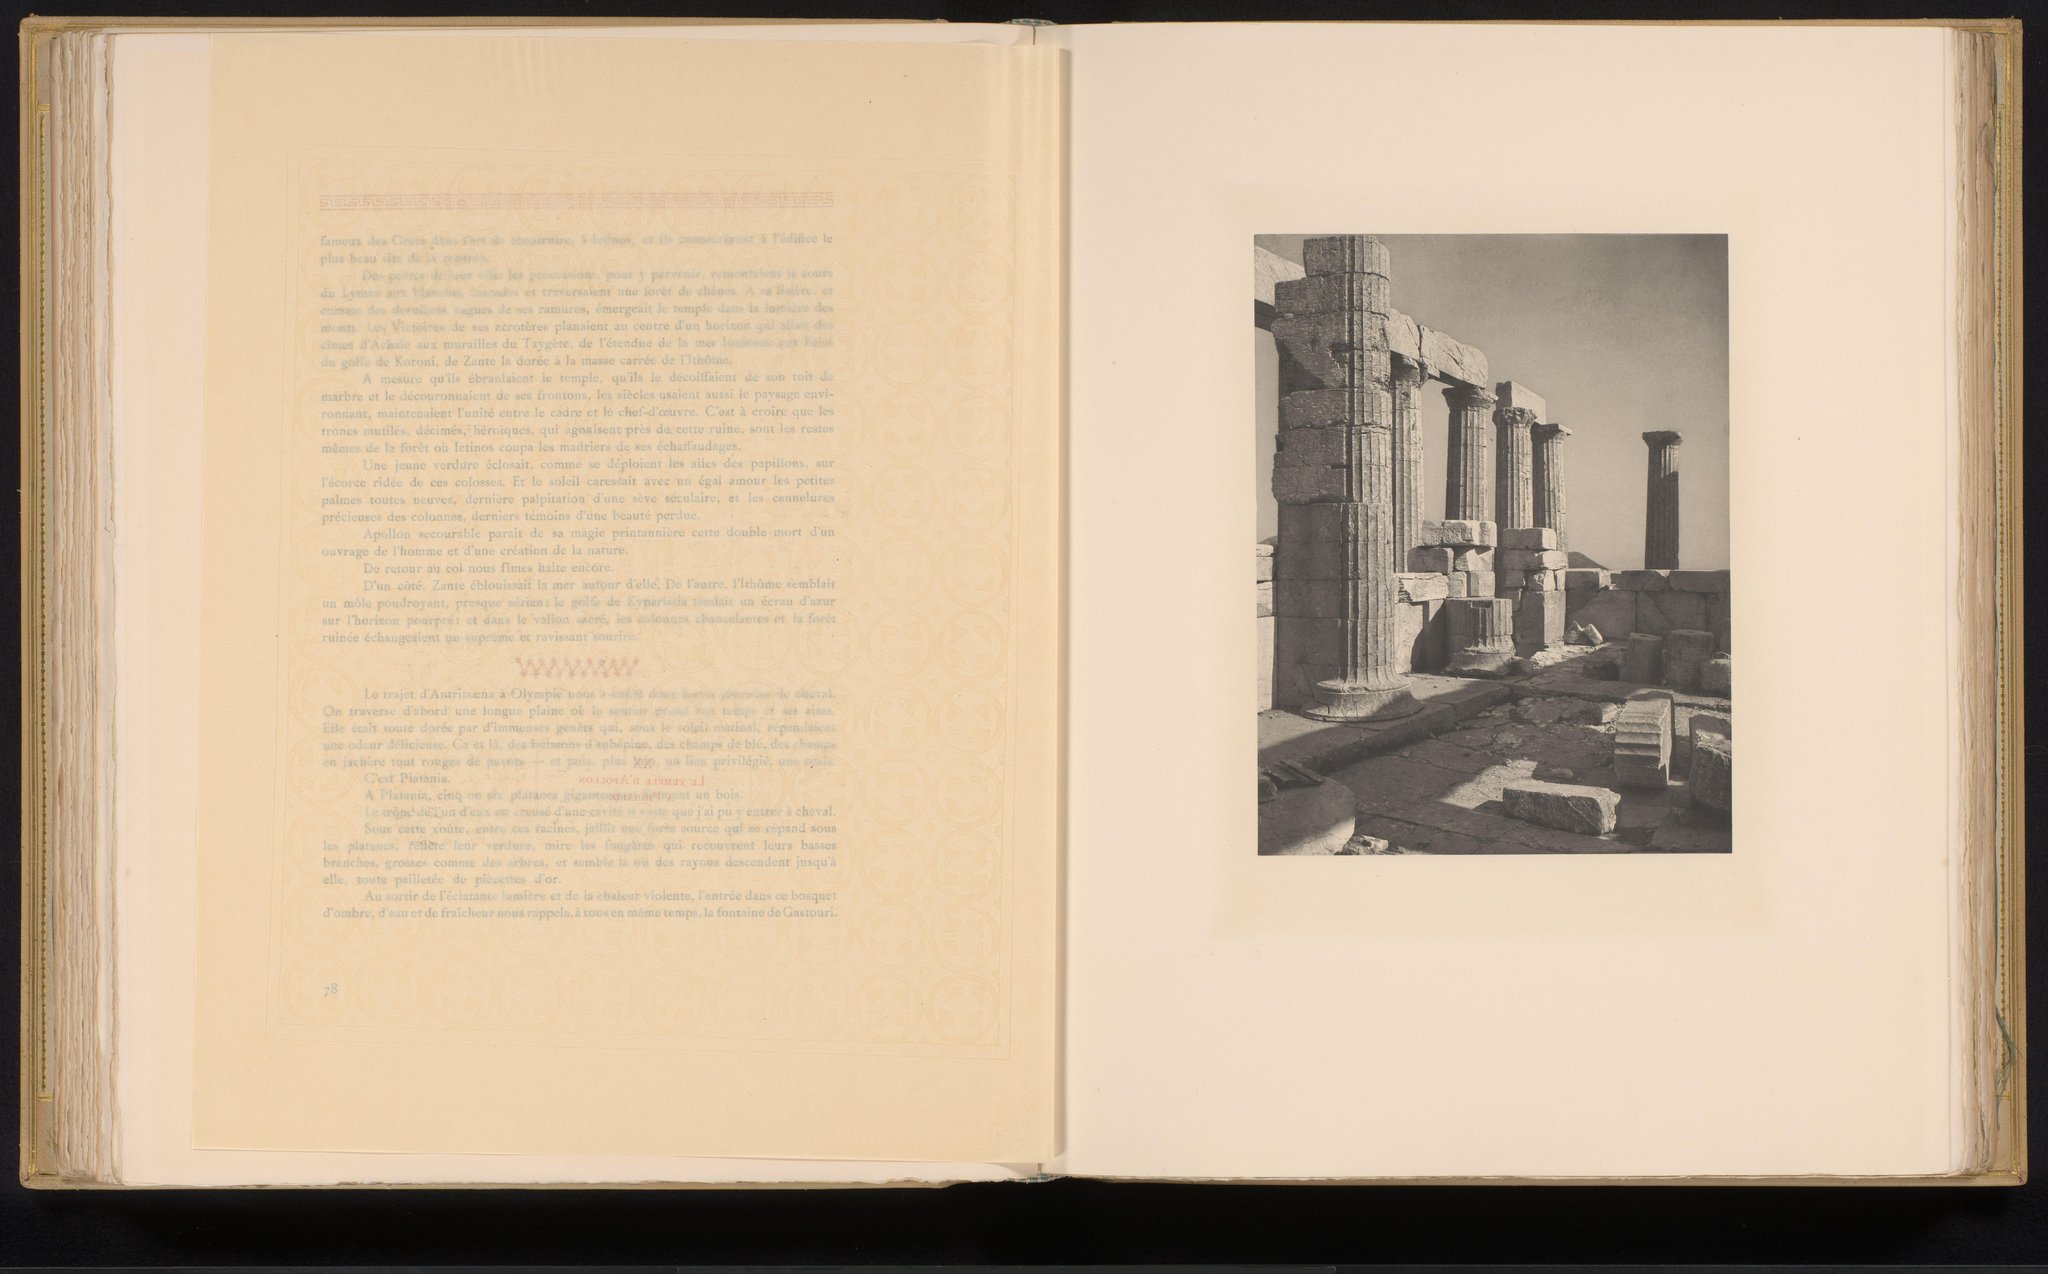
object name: photomechanical print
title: Le temple de d'Apollon a Phigalie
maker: frédéric boissonnas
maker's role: fotograaf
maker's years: 1858-1946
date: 1905-1910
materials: paper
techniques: photoaquatint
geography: berlin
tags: landscape with ruins